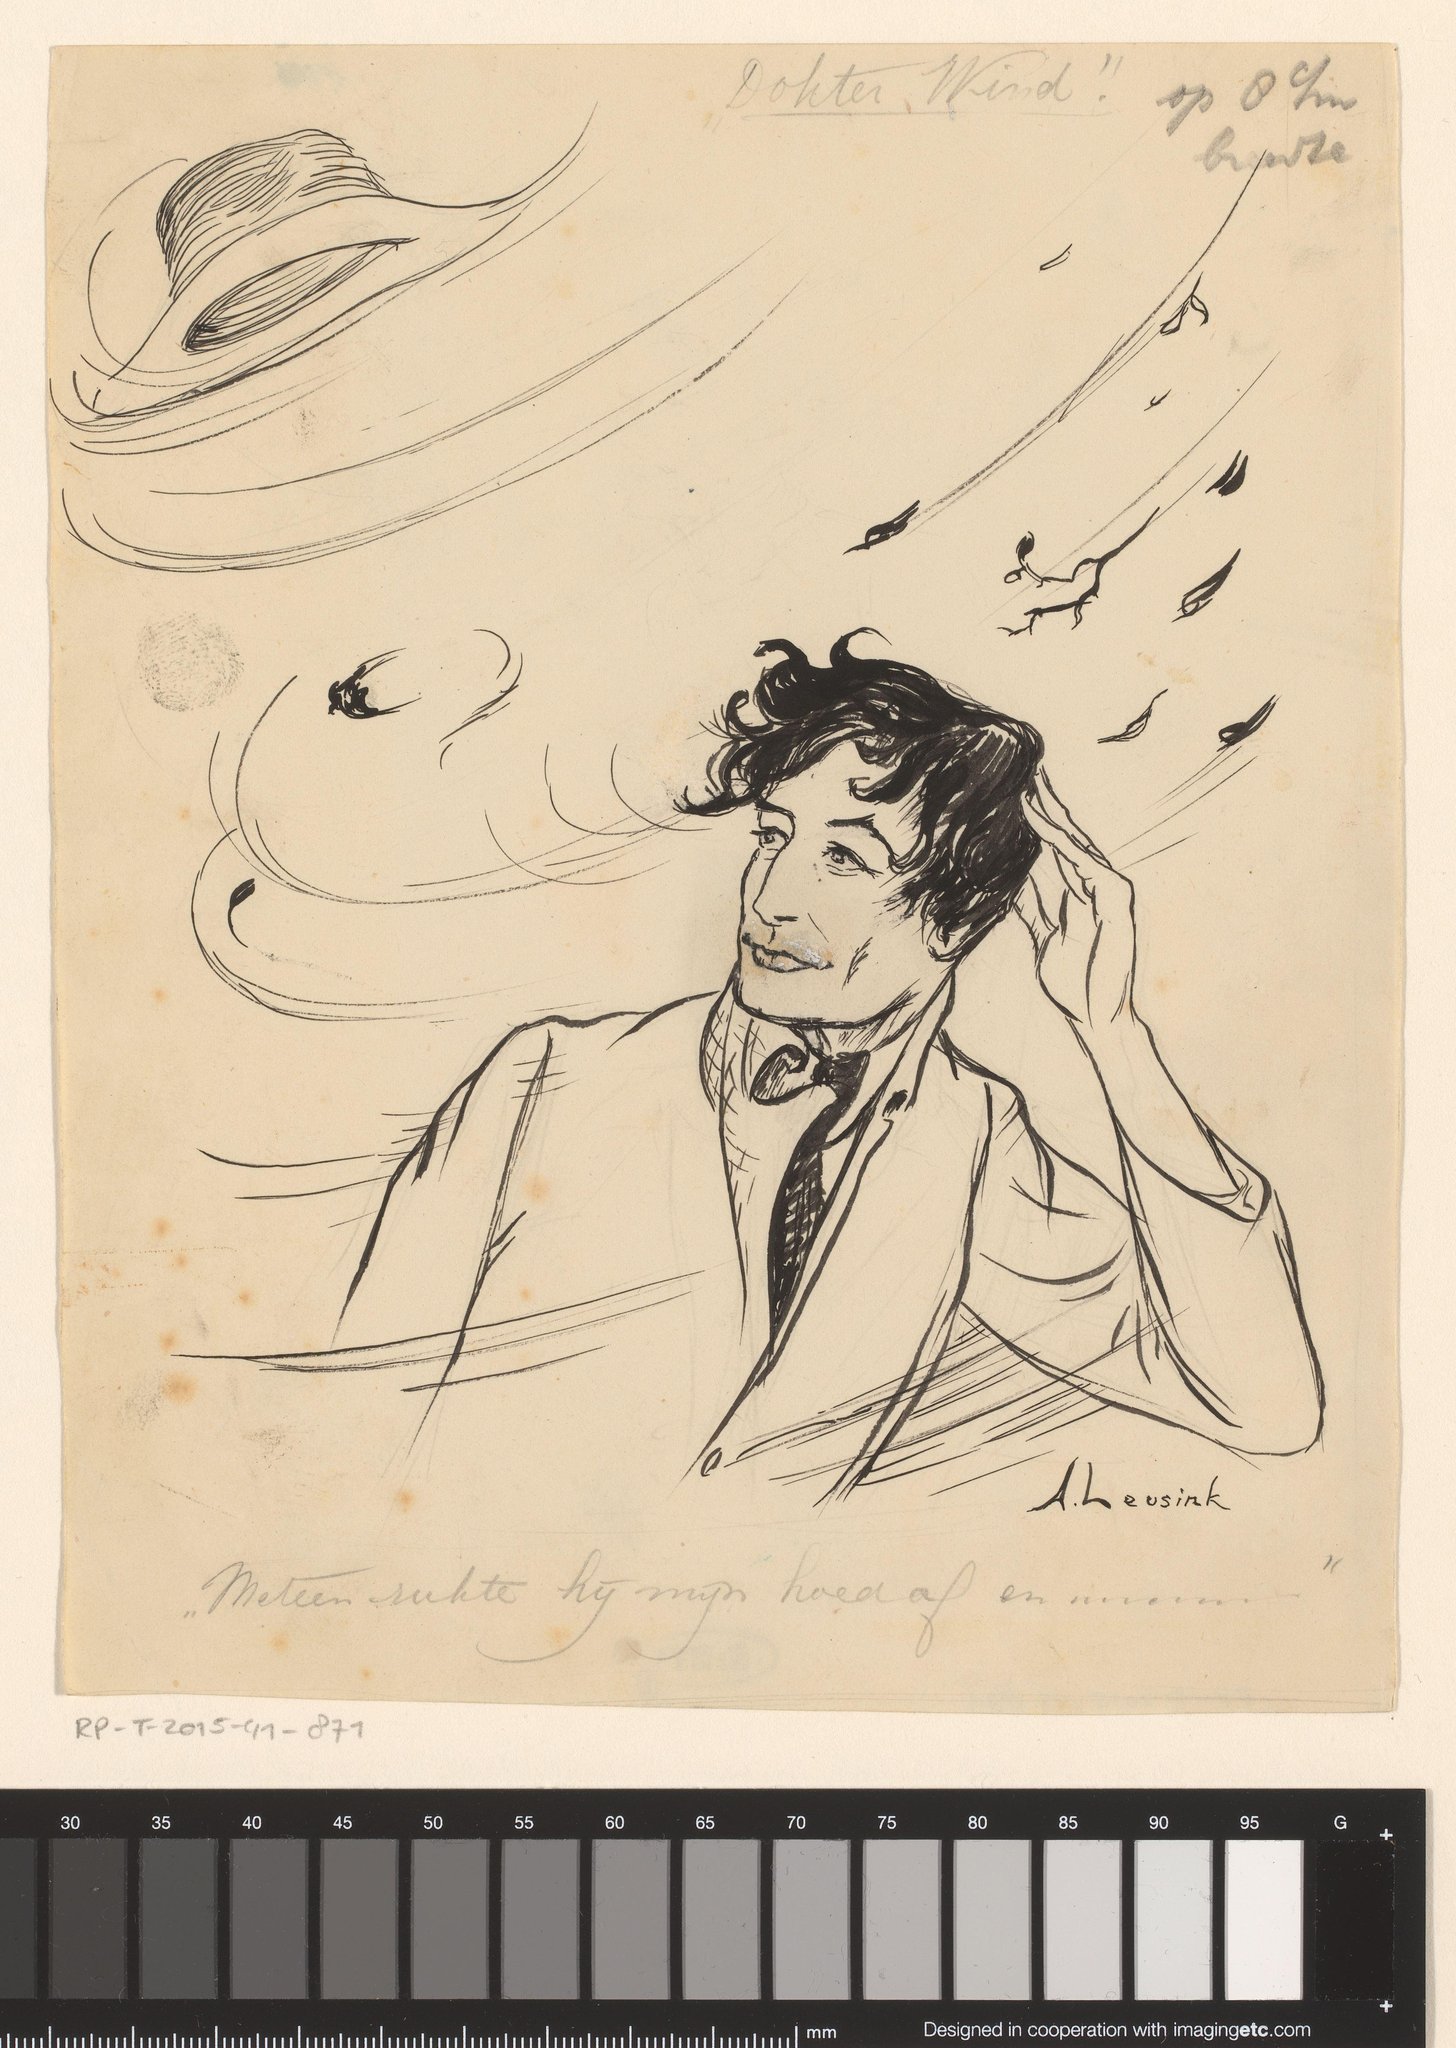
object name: drawing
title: Vaders hoed wordt afgerukt door een windvlaag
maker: anny leusink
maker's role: draughtsman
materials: paint, ink, paper, pencil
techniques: brush, pen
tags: head-gear: hat (+ men's clothes), winds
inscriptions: collector's mark: Lugt 2228, annotation: ‘"Dokter Wind"/ "Meteen rukte hij mijn hoed af en ....."’, :, signature: ‘A. Leusink’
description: Ontwerp voor: Dietz, Henriette e.a. De buitenpartij. Vertellingen voor jongens en meisjes. Amsterdam: Veen, 1926.